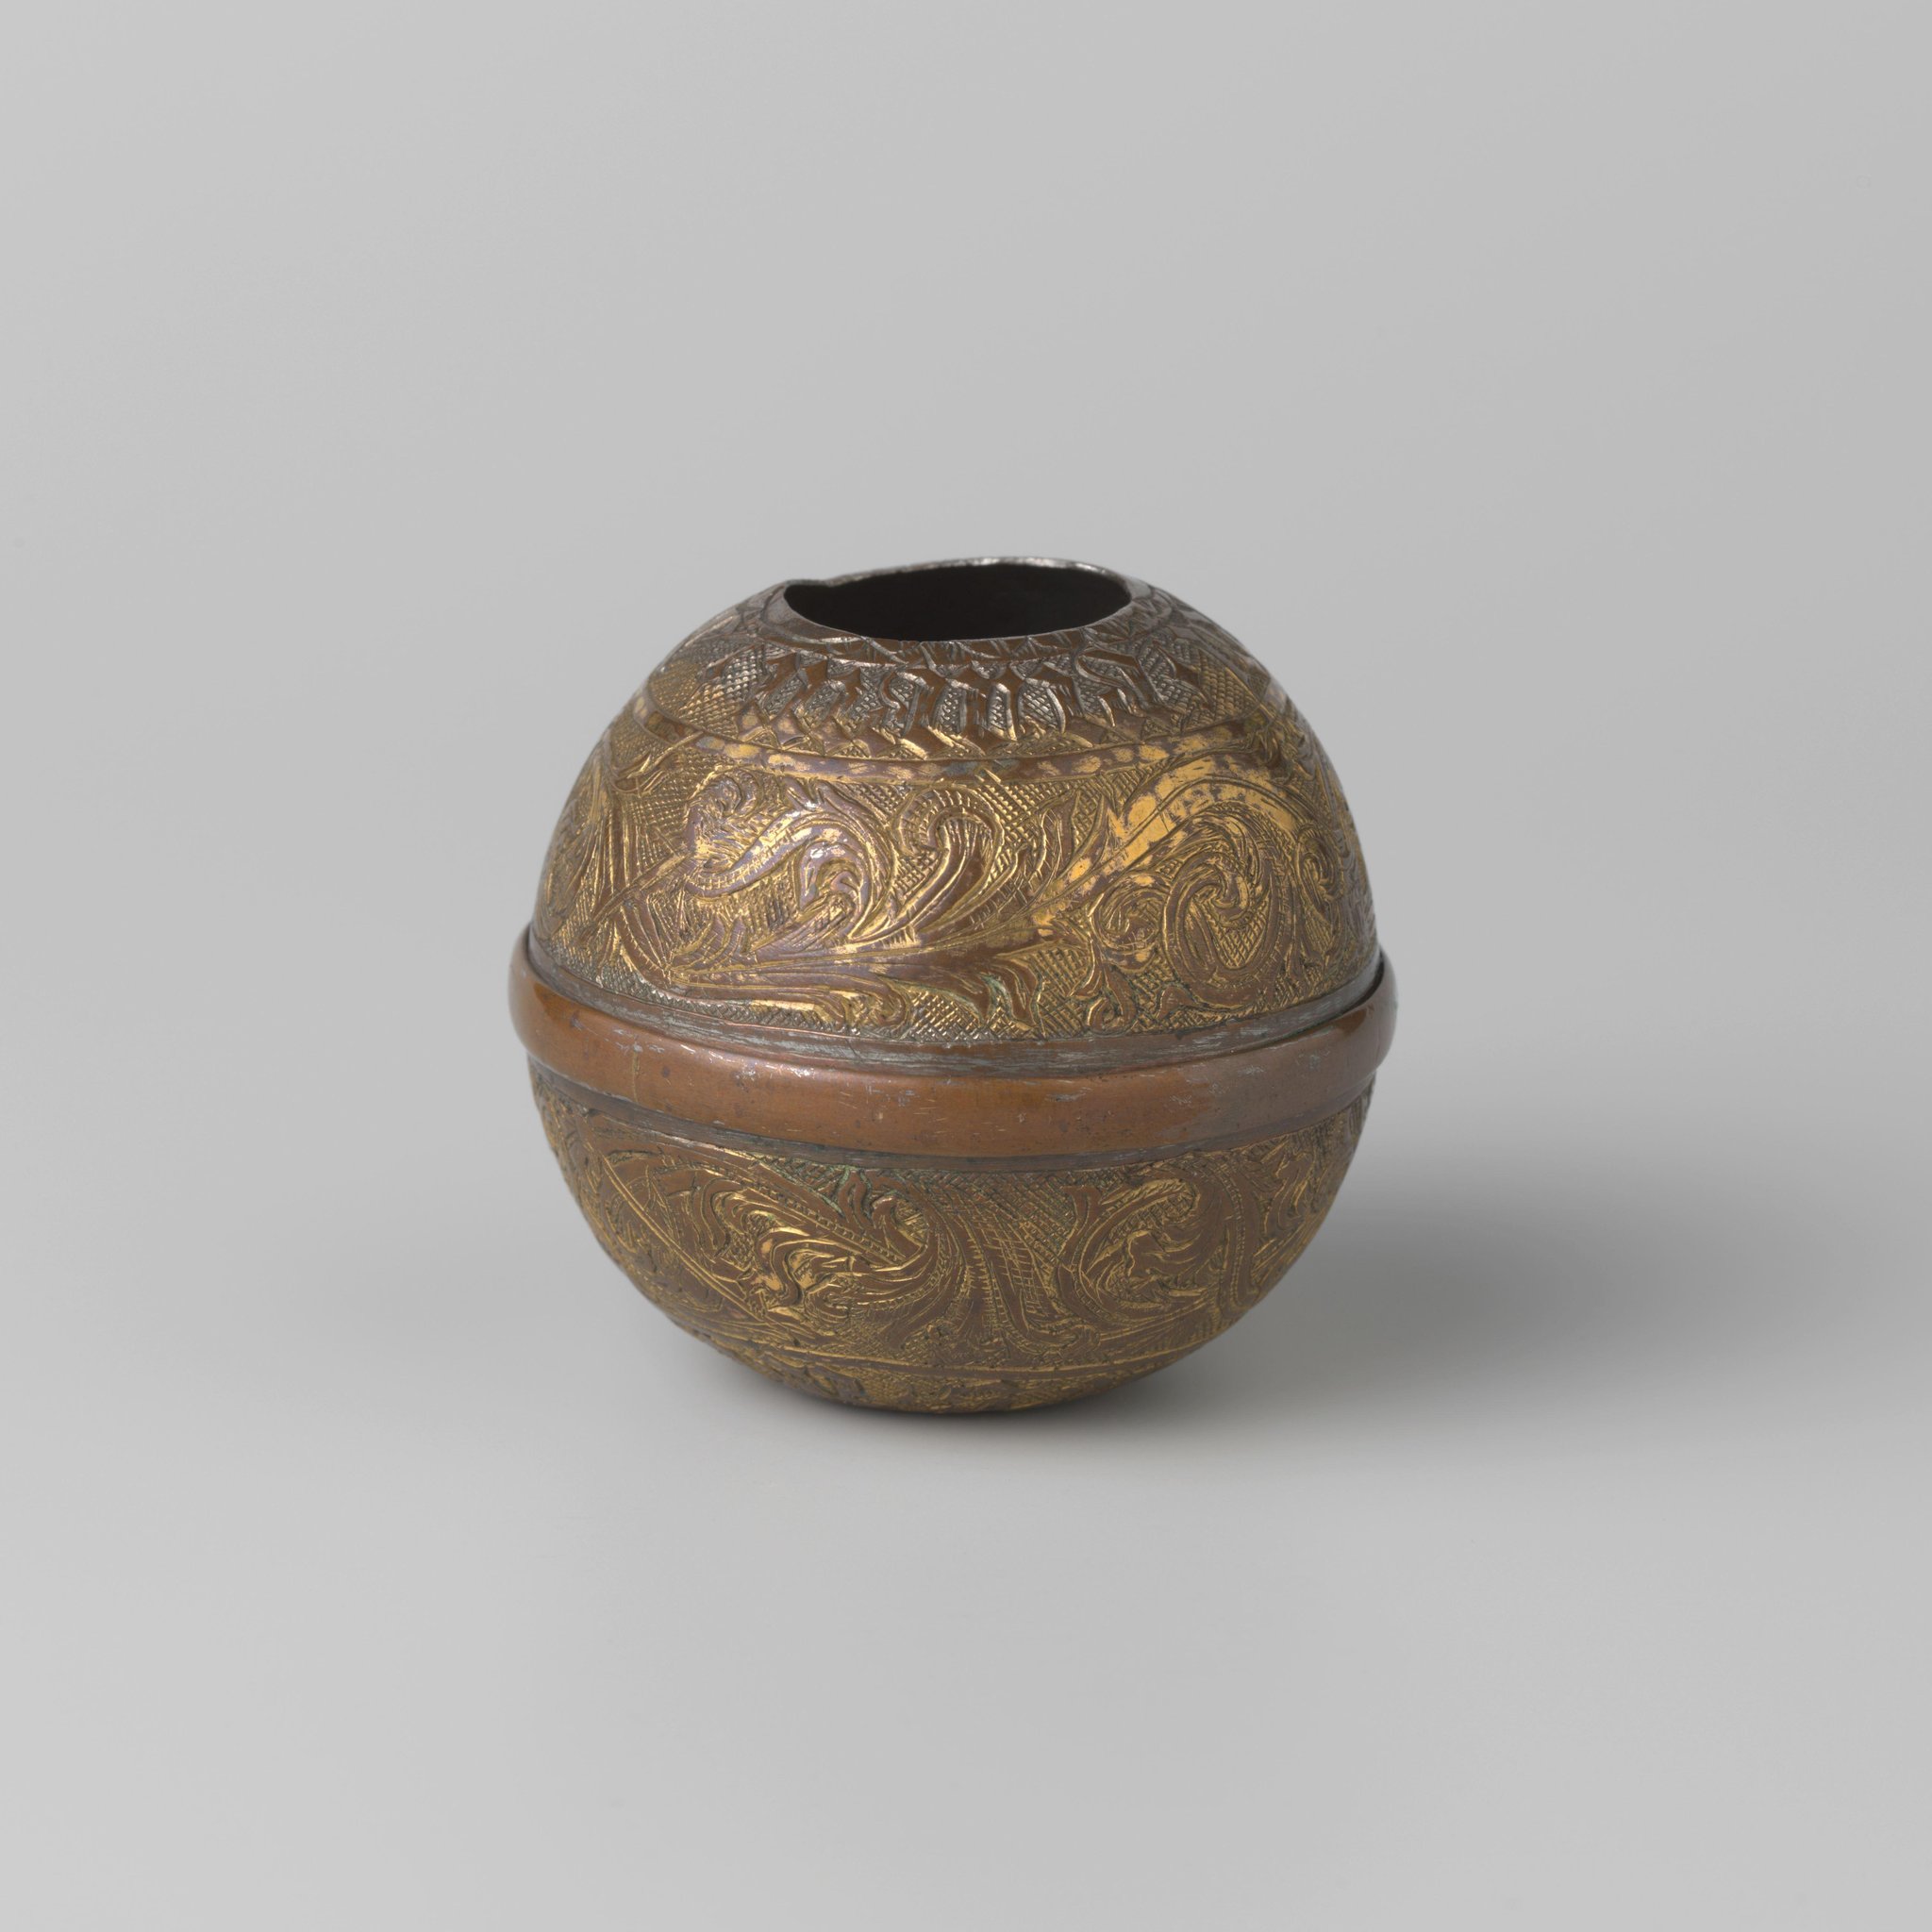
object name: pomellum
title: Pomellum met acanthusblad en tekstband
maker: Anonymous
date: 1500-1550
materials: copper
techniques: metalworking, engraving, gilding, tinning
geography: germany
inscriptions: inscription: ‘jesus.maria.johes.’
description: Pommel (decorative ball for a cope). Copper. Germany (?), c. 1500 - 1550.